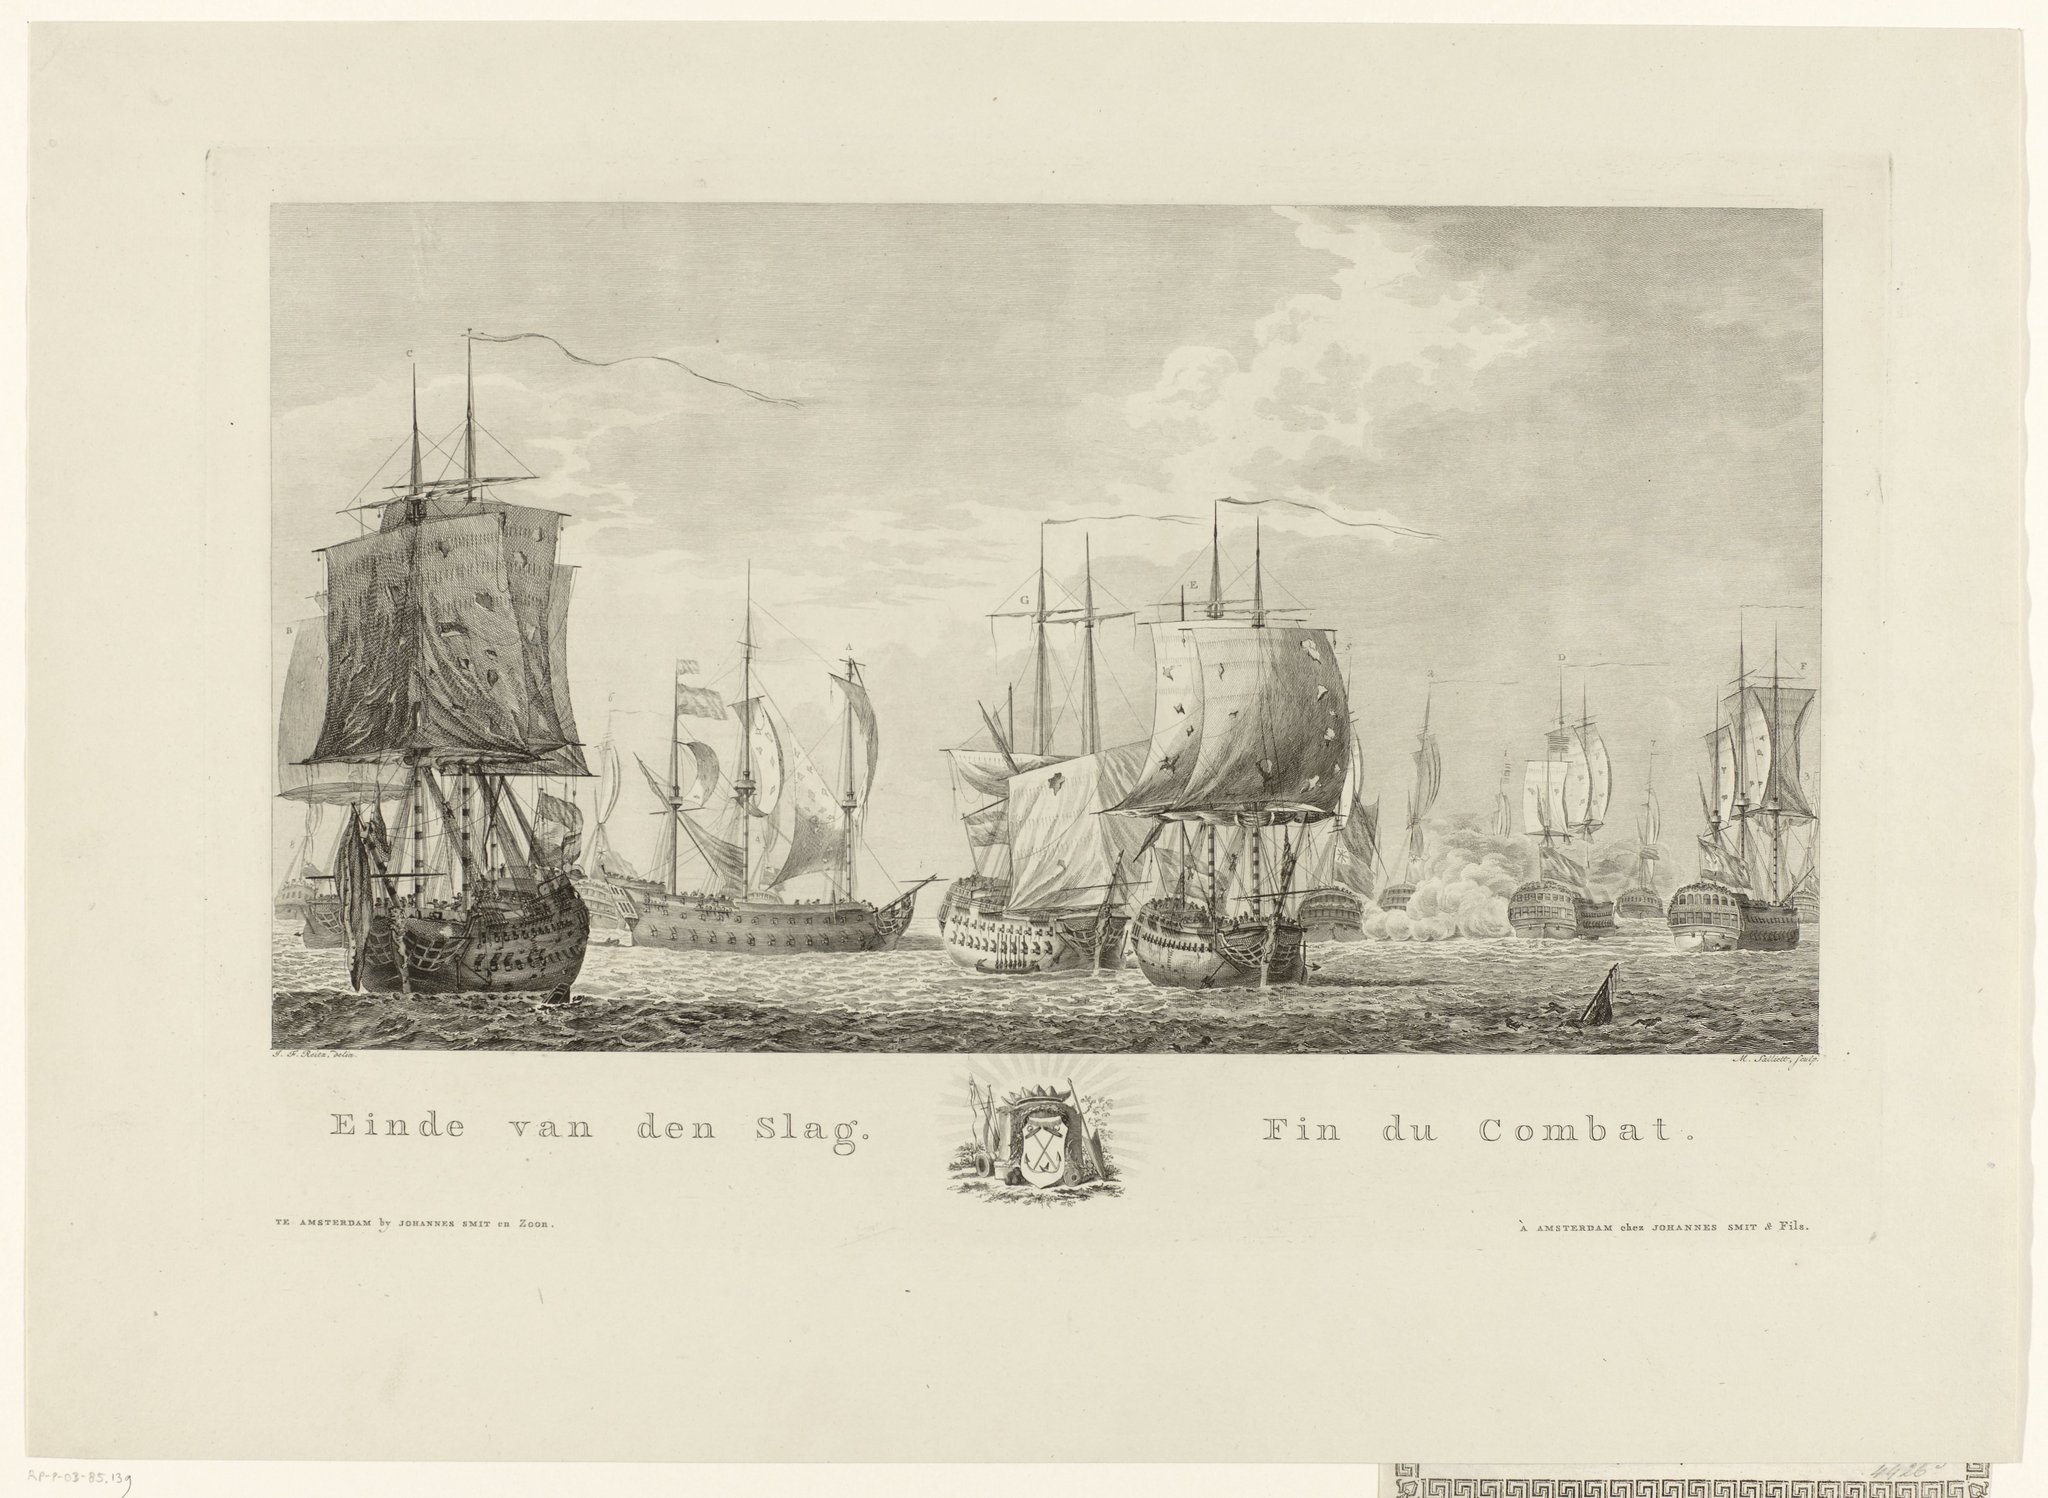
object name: print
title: Einde van de zeeslag bij Doggersbank, 1781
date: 1782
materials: paper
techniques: engraving, etching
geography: amsterdam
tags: the hague, johan arnold zoutman, hyde parker, battle (+ naval force)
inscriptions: collector's mark: Lugt 2228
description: Het einde van de zeeslag bij Doggersbank op 5 augustus 1781 tussen de Nederlandse vloot onder schout-bij-nacht Johan Zoutman en de Engelse vloot onder vice-admiraal Hyde Parker. In de marge de titels in het Nederlands en Frans. Onderdeel van een serie van drie platen van de Zeeslag op de Doggersbank. Bij de prent behoort een los uitgeknipt tekstblad met een uitleg van de plaat.